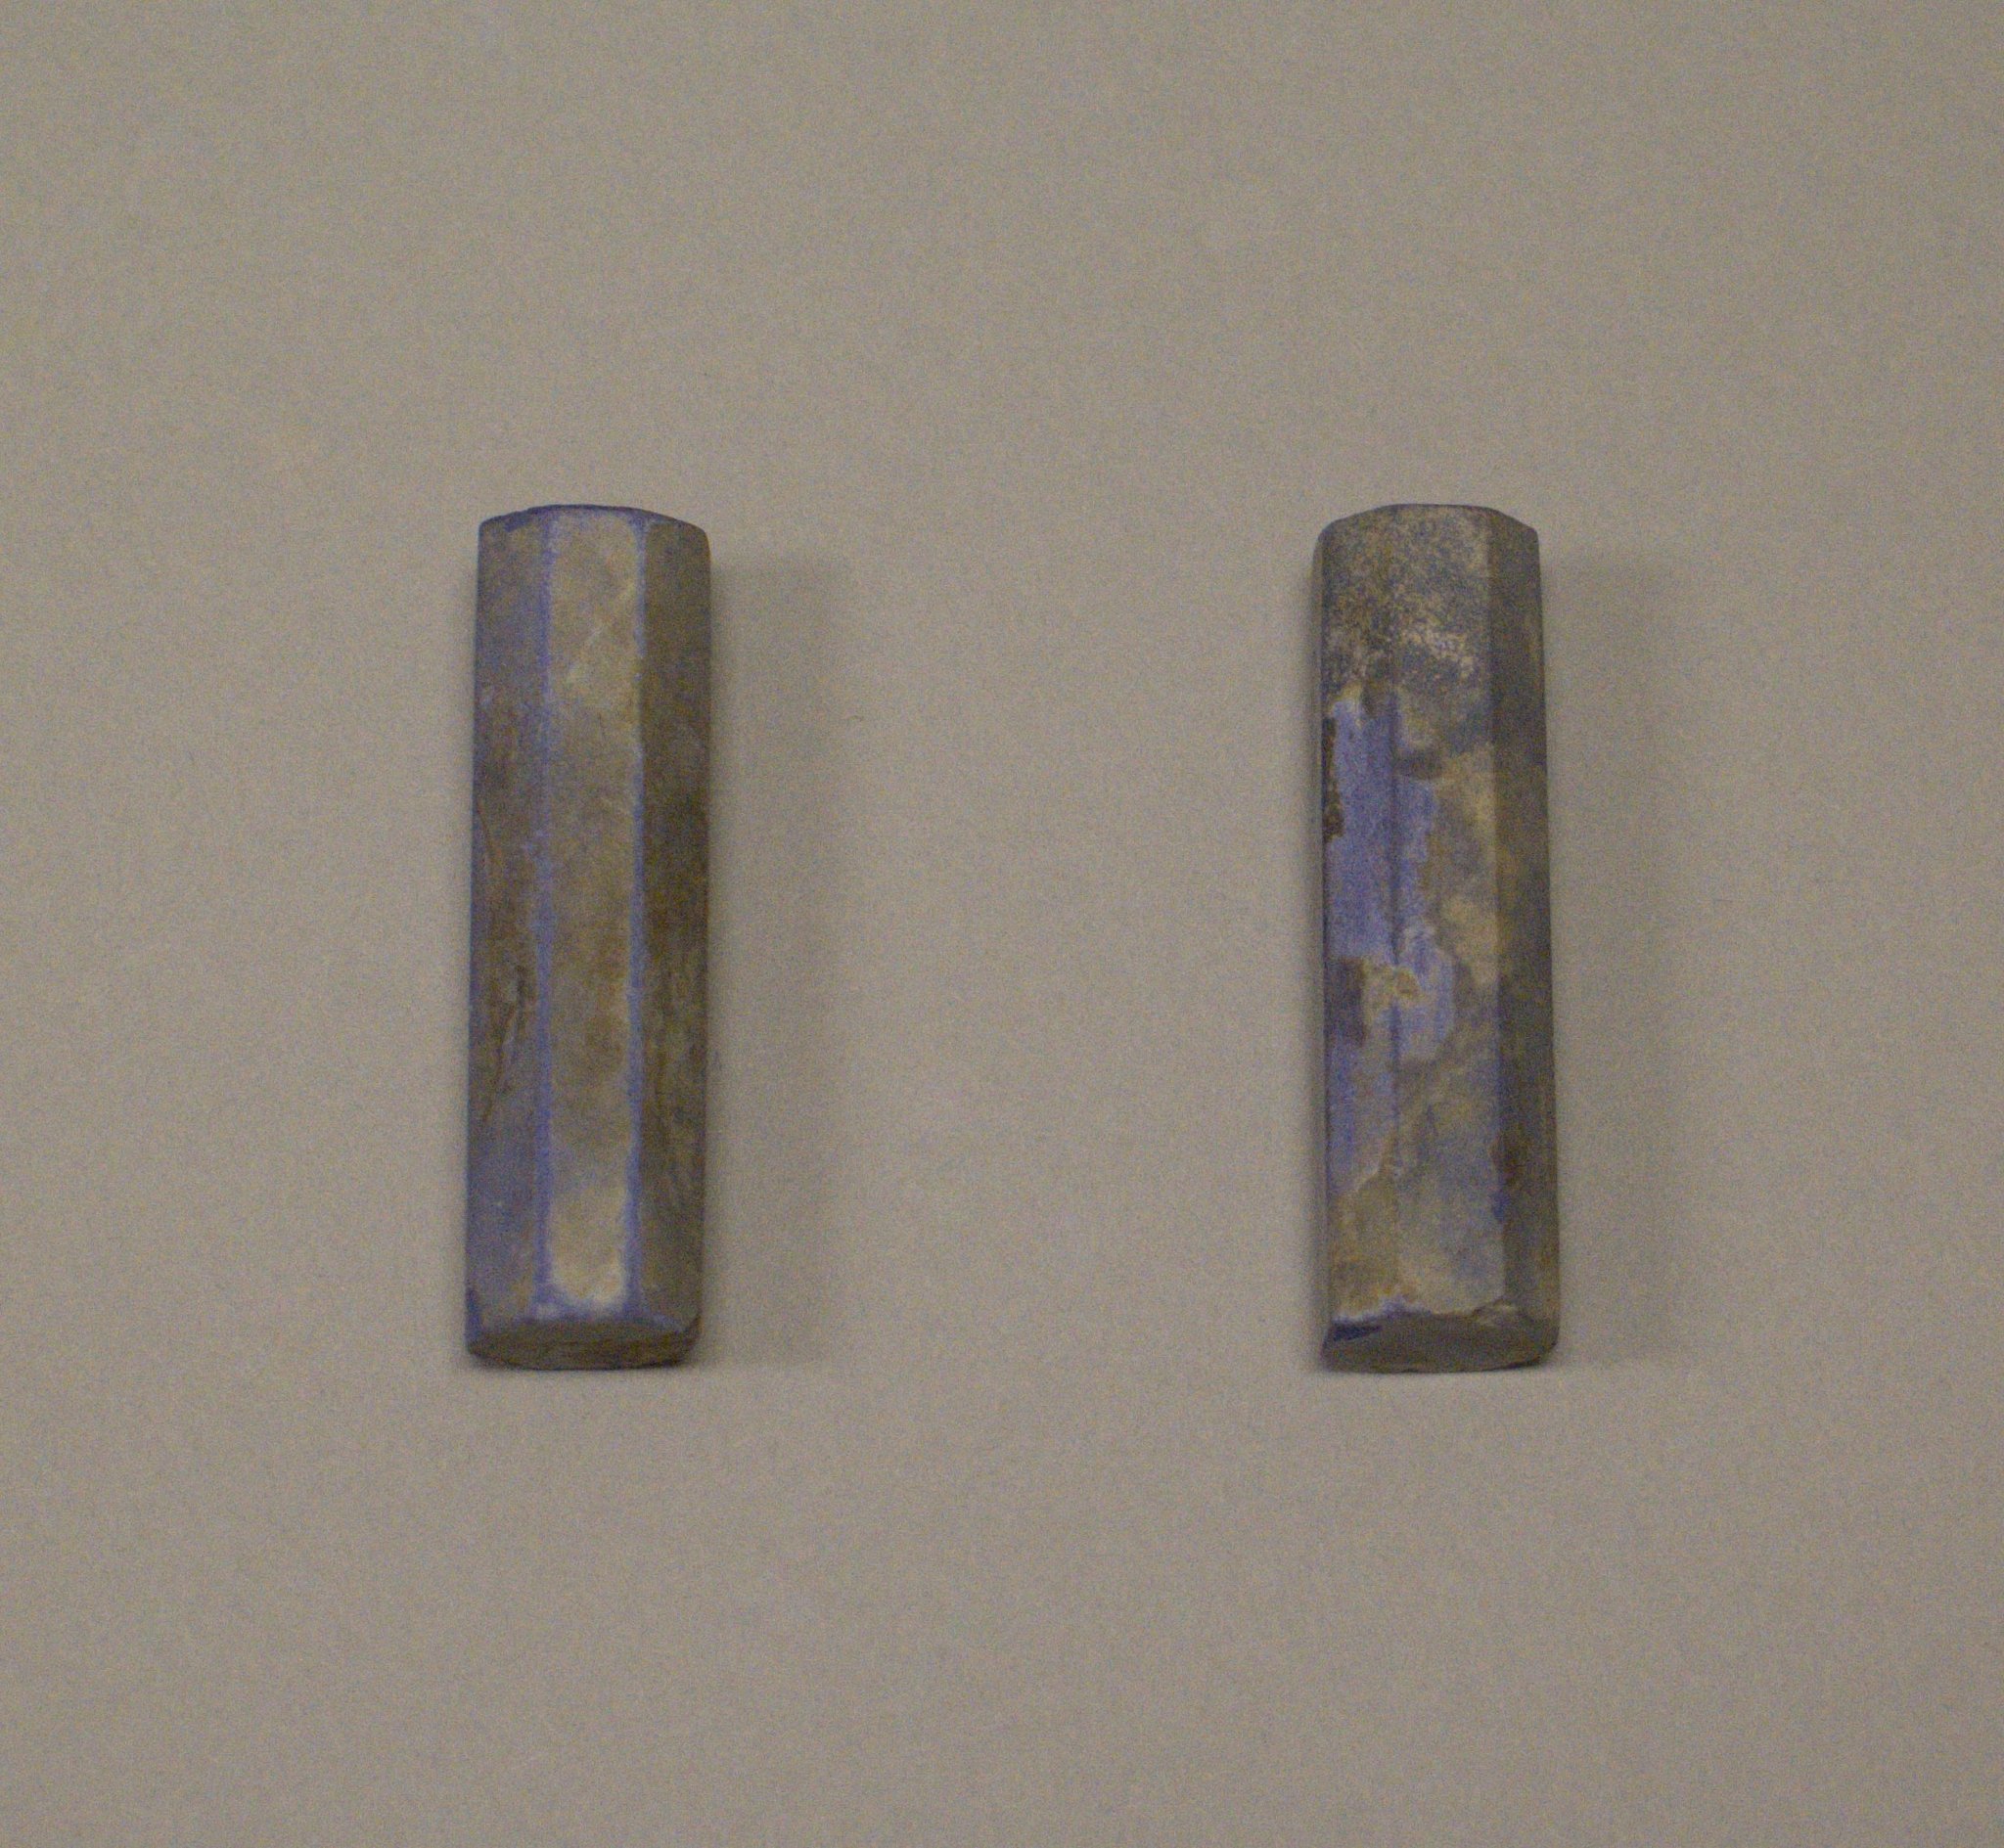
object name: stick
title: Pair of Octagonal Sticks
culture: chinese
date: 200-1 BCE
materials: copper